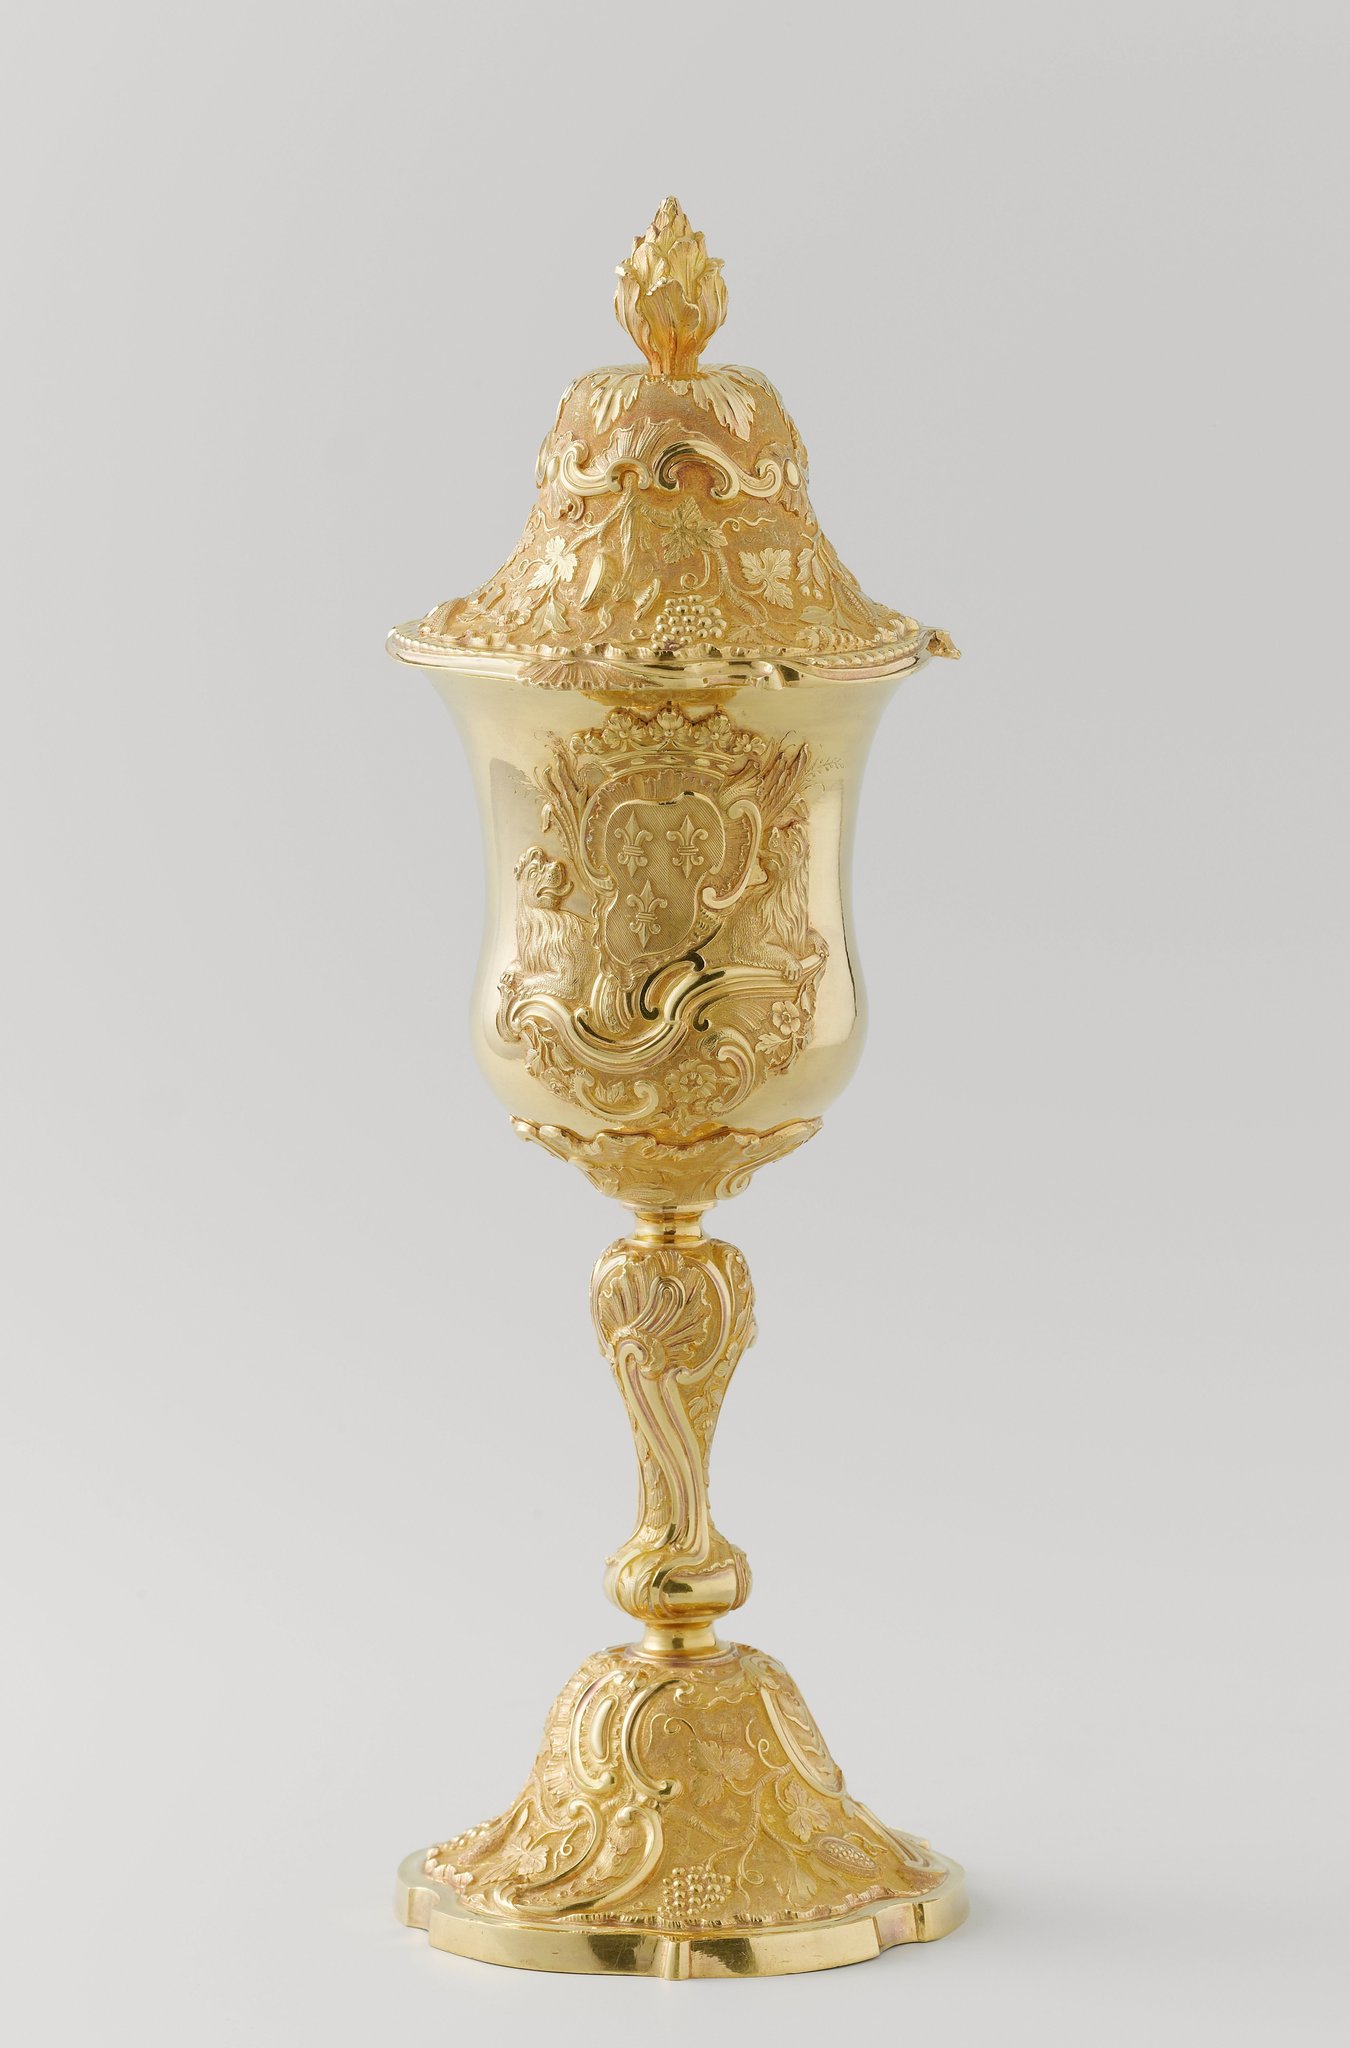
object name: goblet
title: Bokaal met deksel, van goud, met het wapen Dedel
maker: Anonymous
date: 1743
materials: gold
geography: the hague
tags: vine, rocaille ornament, armorial bearing, heraldry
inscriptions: coat of arms, alloy mark, town mark, maker's mark, date letter: ‘W’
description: Cup. Gold. The Hague, 1743, maker's mark a bird.